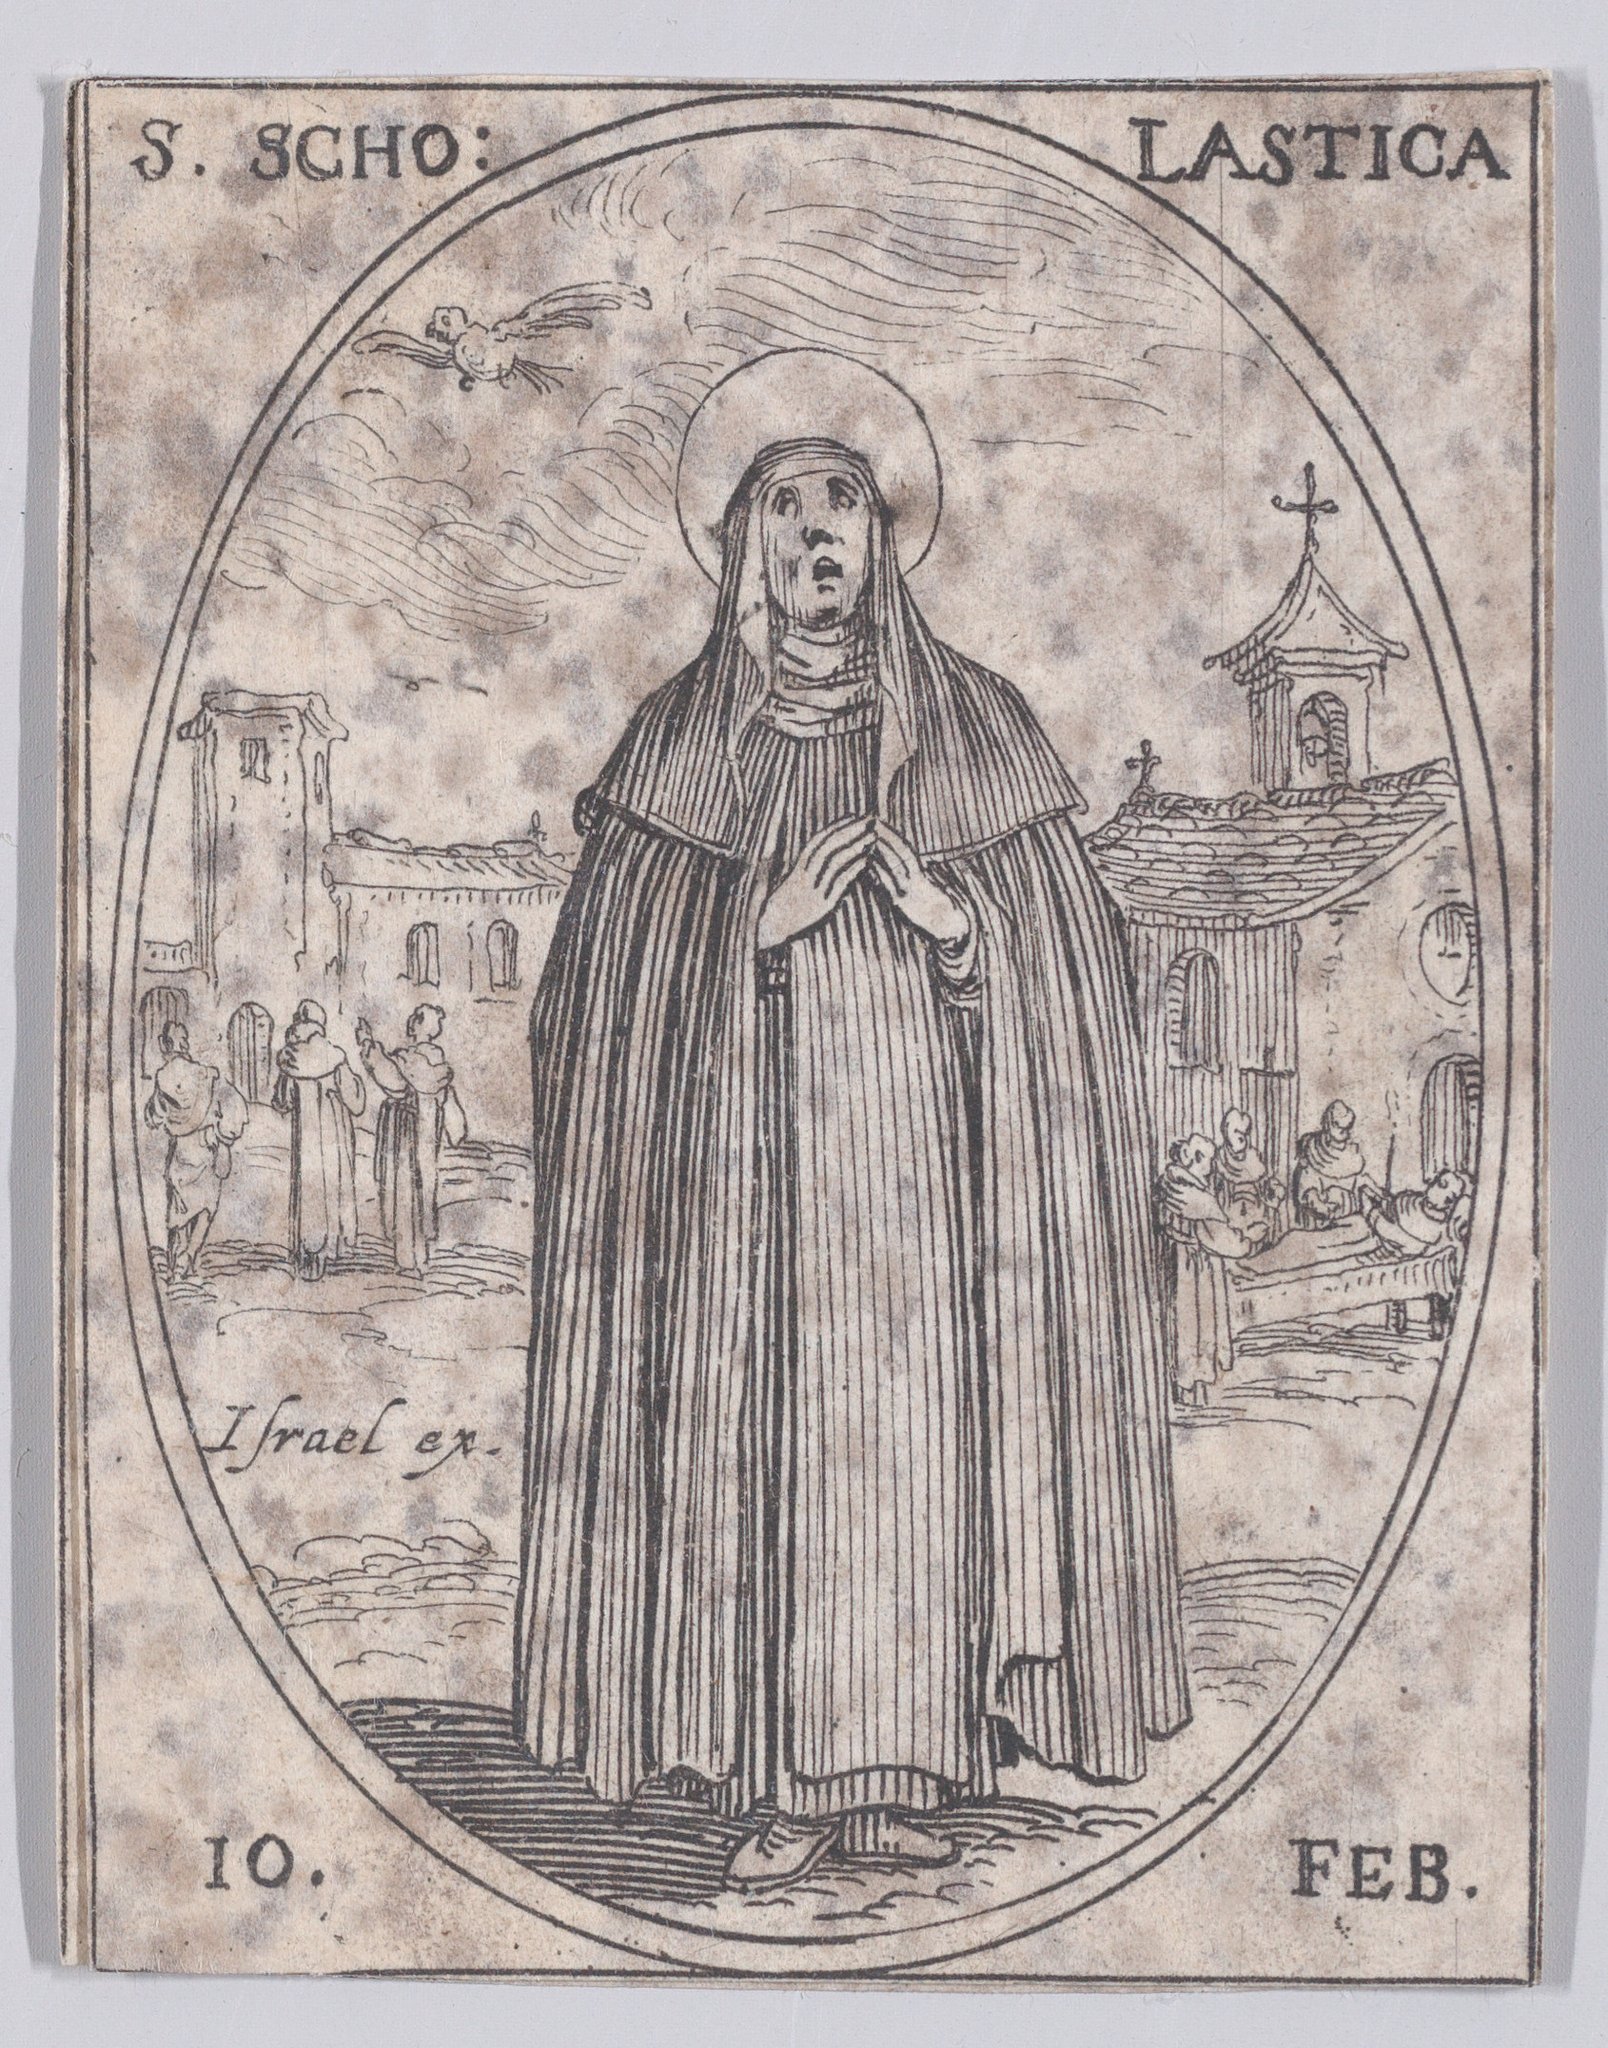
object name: print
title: Ste. Scholastique (St. Scholastica), February 10th, from "Les Images De Tous Les Saincts et Saintes de L'Année" (Images of All of the Saints and Religious Events of the Year)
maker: jacques callot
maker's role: artist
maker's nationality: french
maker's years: 1592-1635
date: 1636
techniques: etching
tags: women,saints